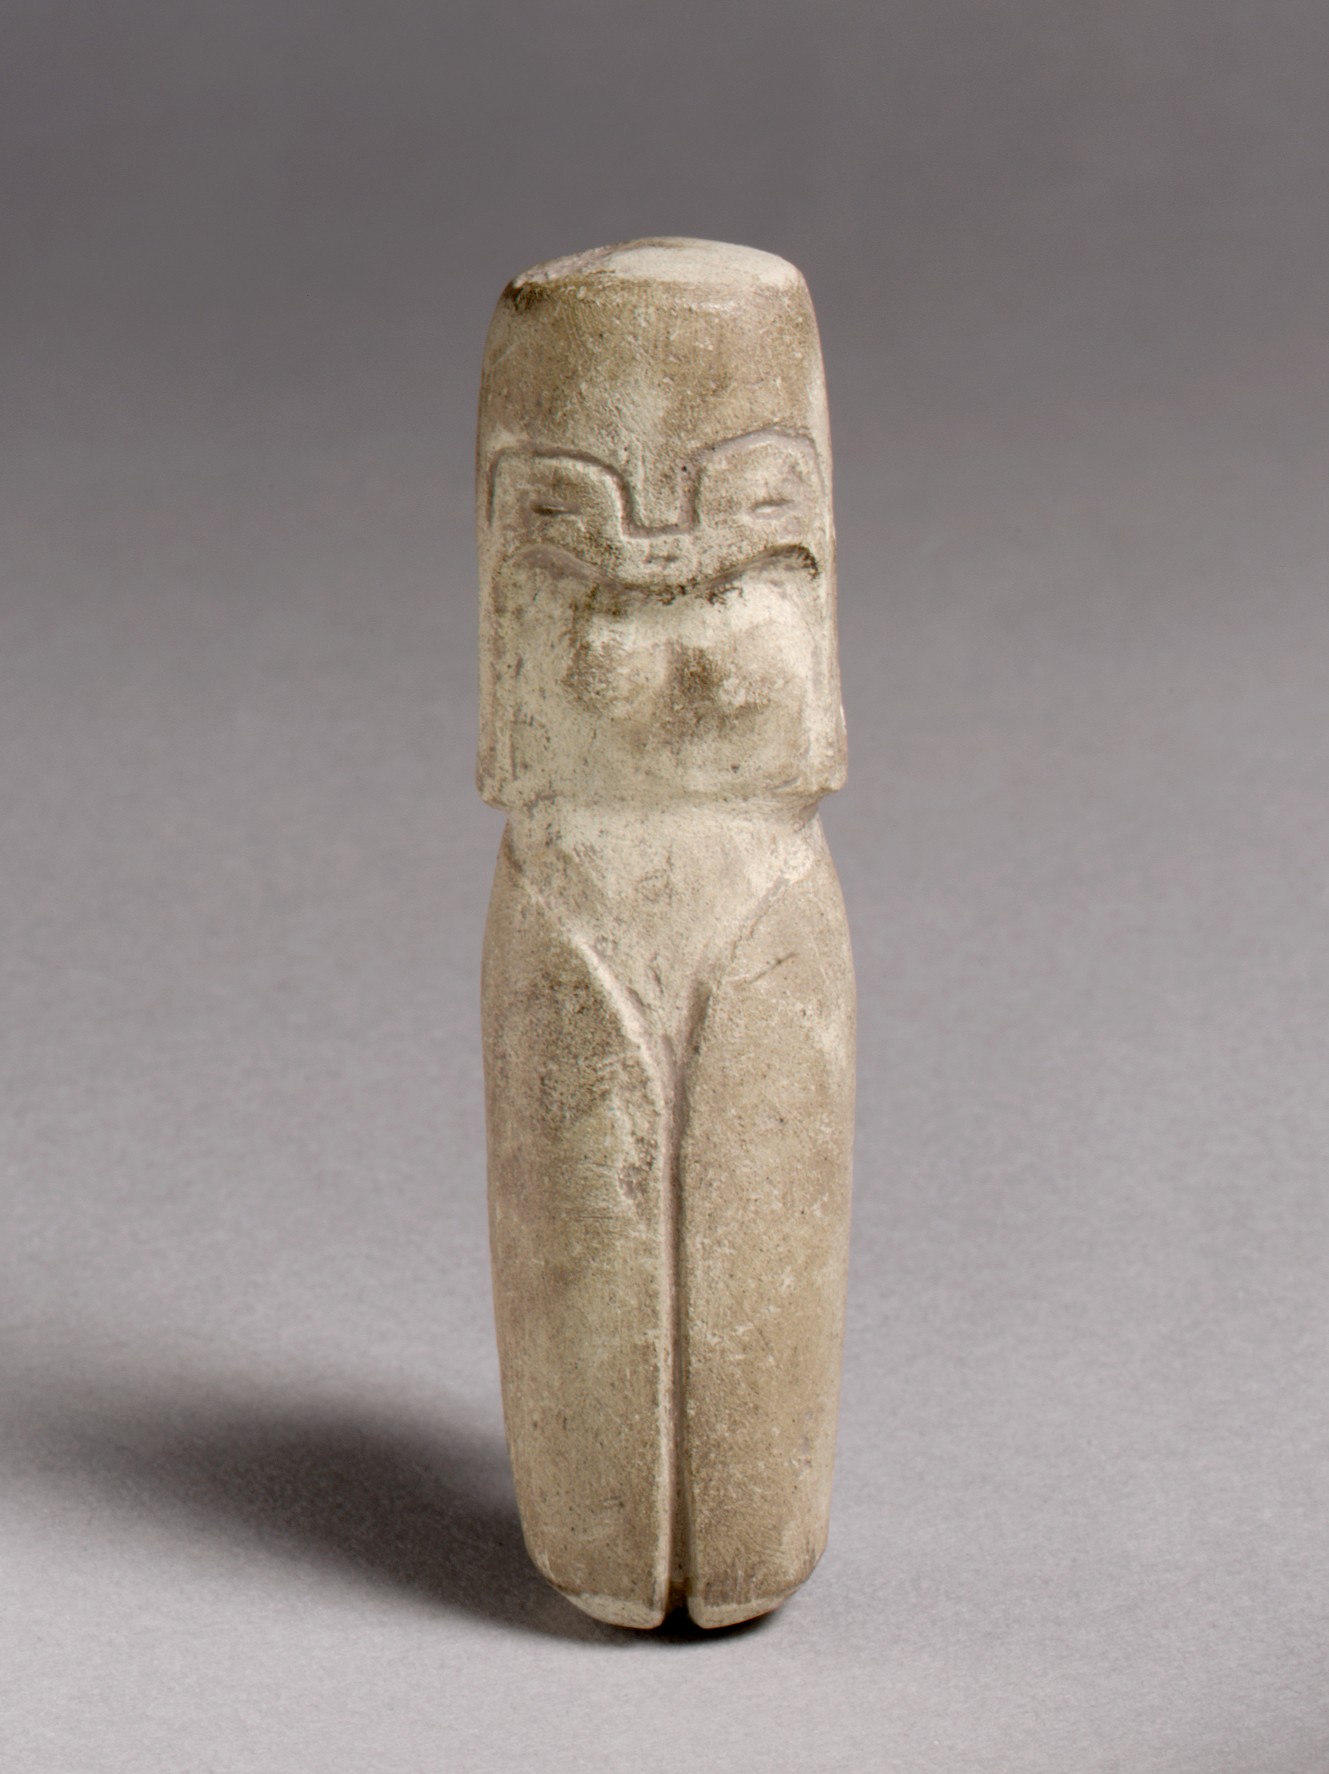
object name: female figure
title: Figure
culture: valdivia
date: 3000-2001 BCE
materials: stone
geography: ecuador